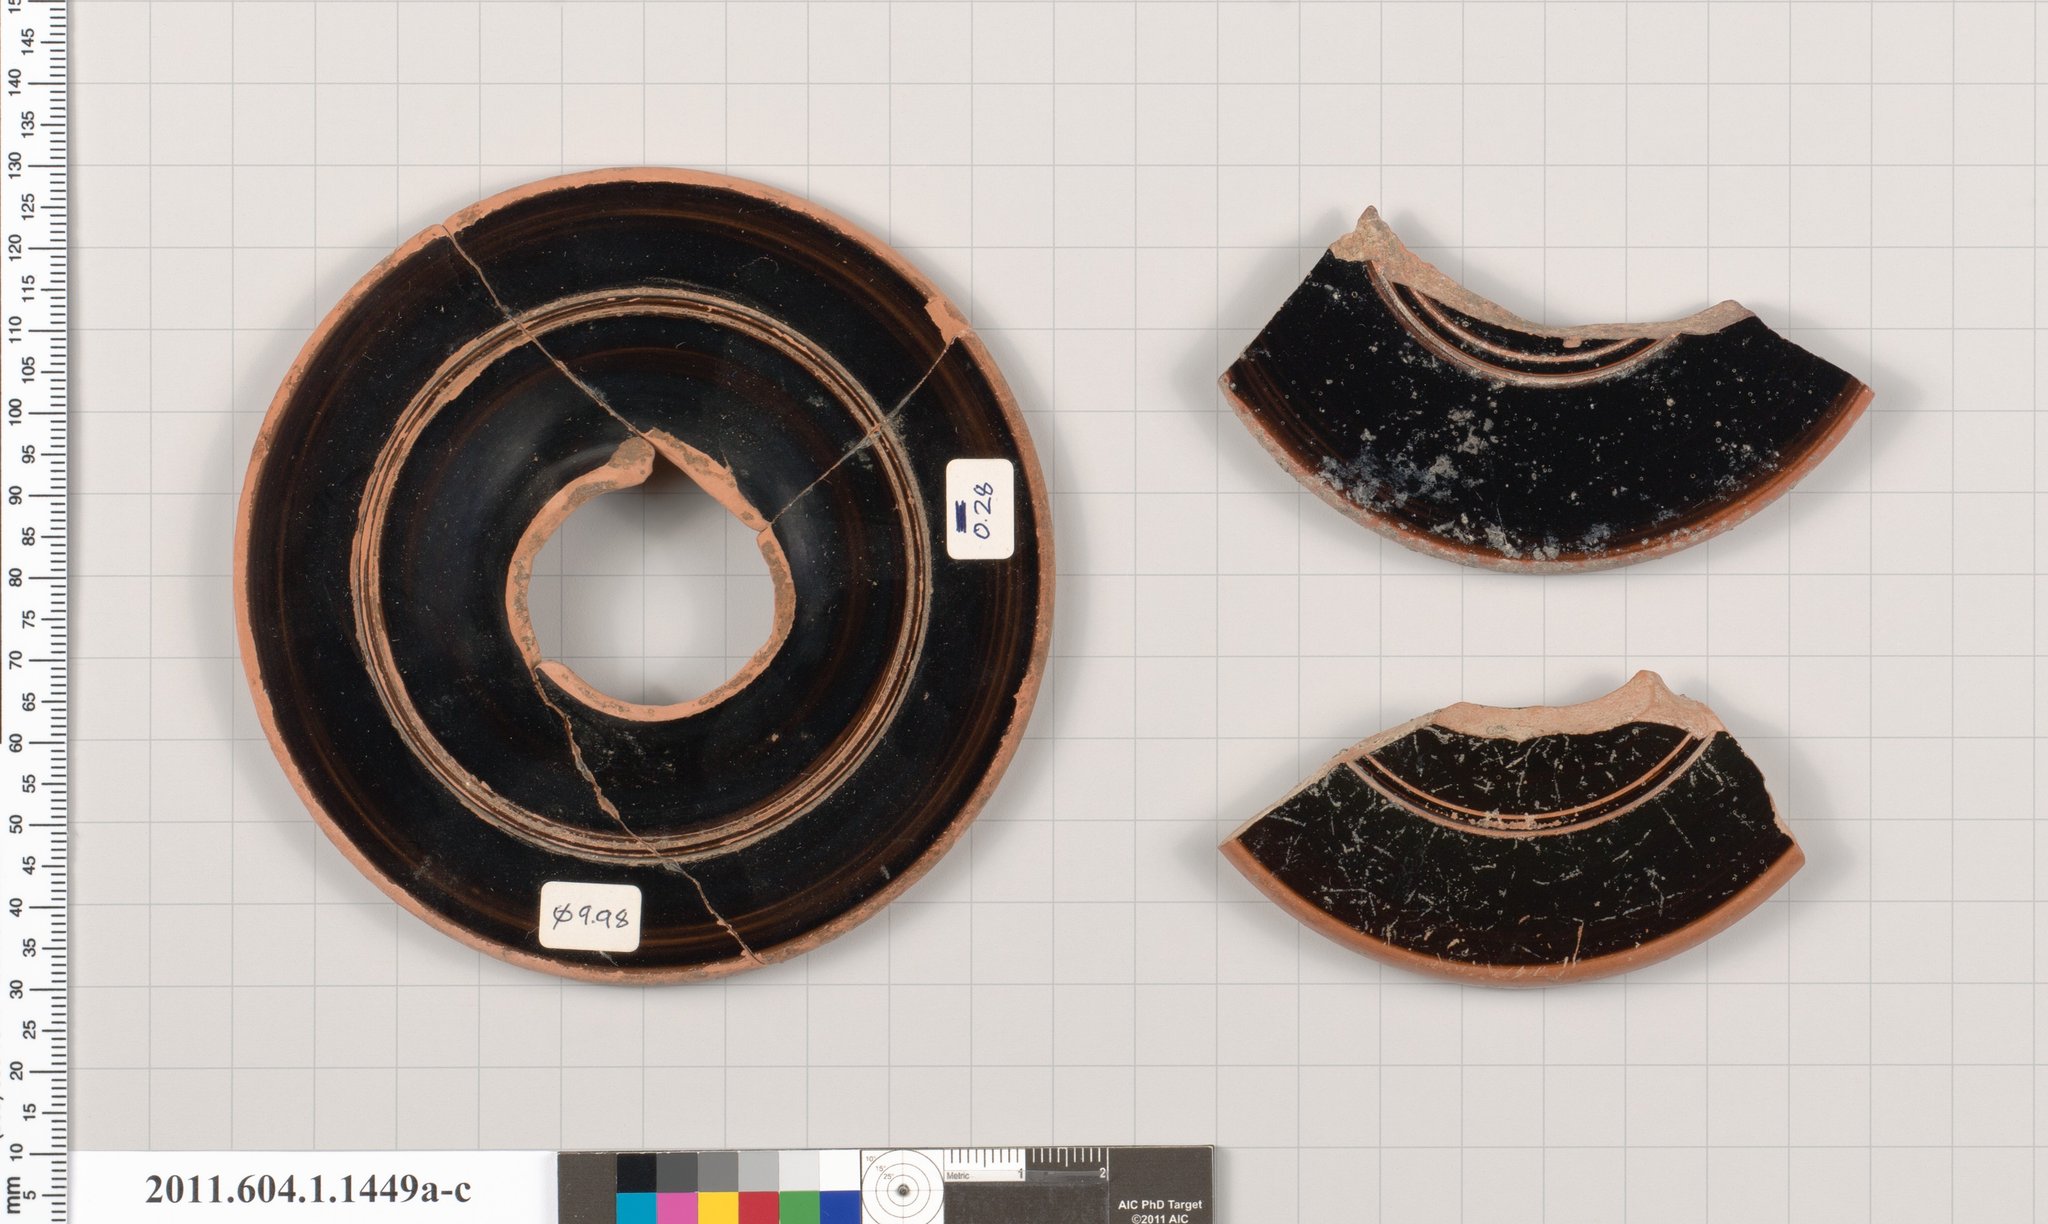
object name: kylix fragment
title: Terracotta fragments of kylikes (drinking cups)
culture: greek, attic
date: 500-401 BCE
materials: terracotta